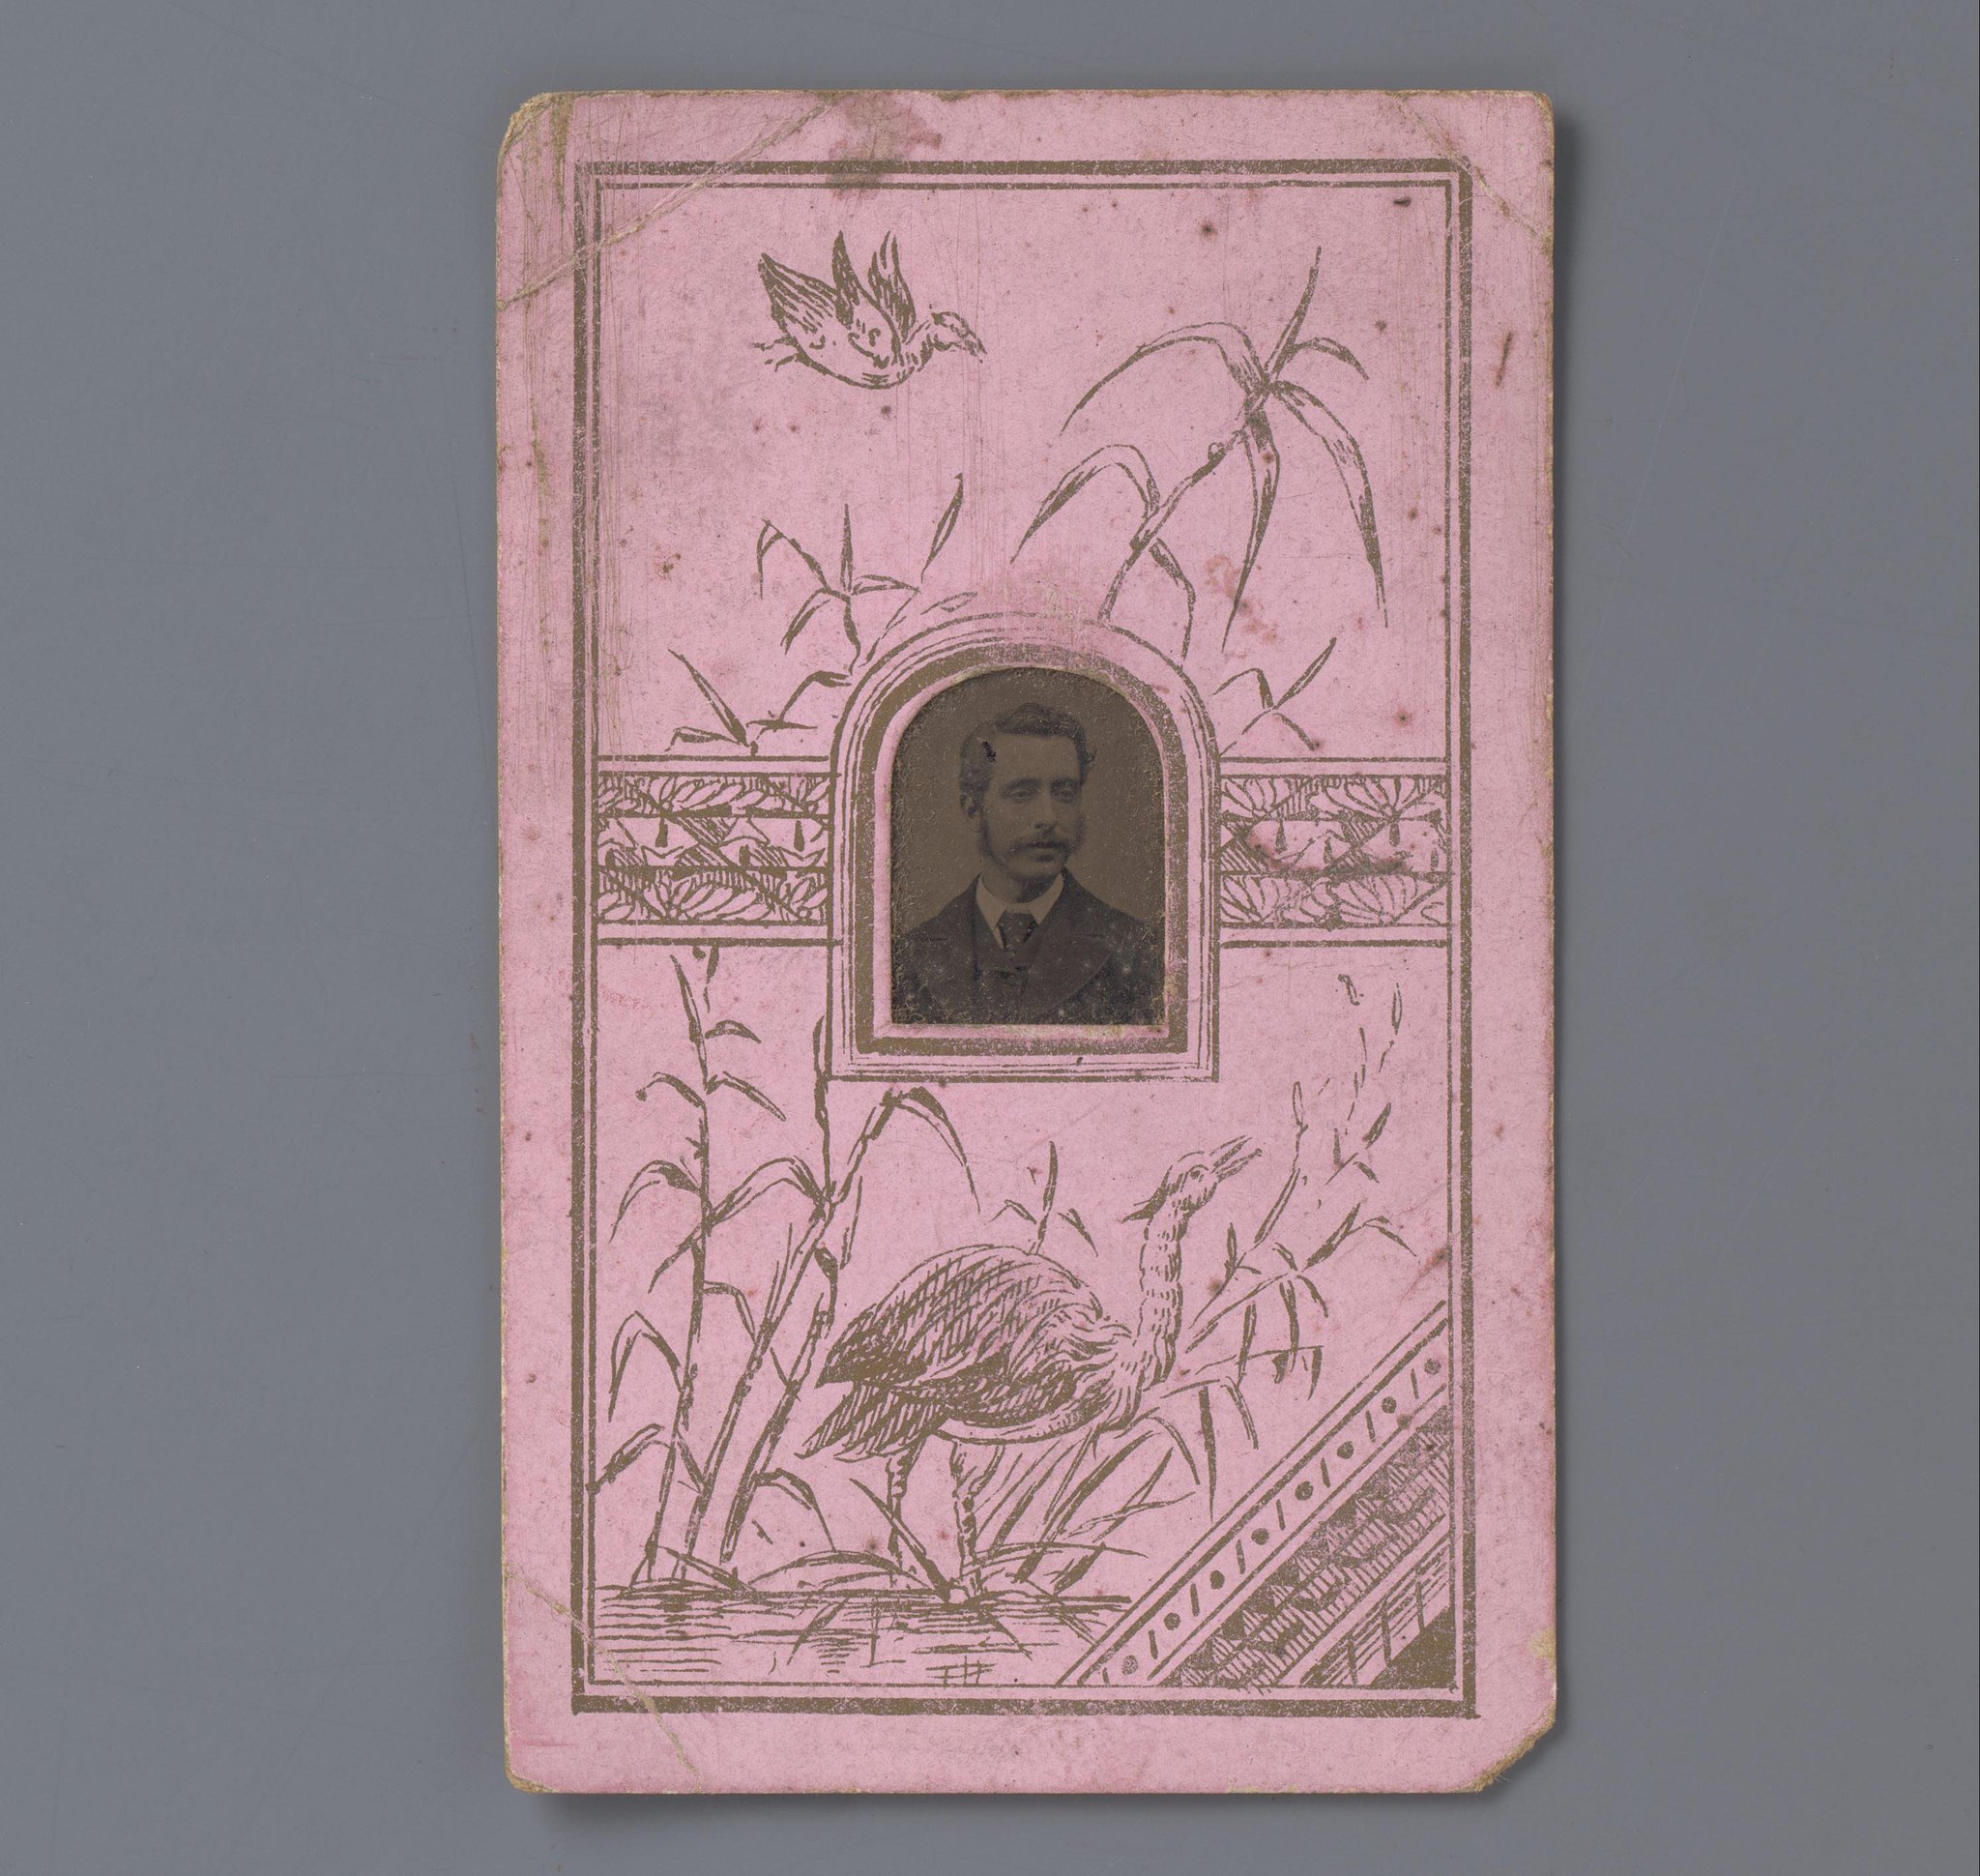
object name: photograph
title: Portret van een onbekende man met snor en bakkebaarden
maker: john george kirby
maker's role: fotograaf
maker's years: 1849-1913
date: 1855-1900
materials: cardboard, iron, paper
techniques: ferrotyping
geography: london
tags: sideburns, moustache, historical persons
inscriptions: inscription: ‘J. G. KIRBY,/ Photographer,/ 295, Edgware Road, London, W./ PRICES./ (...)/ Photography in all its Branches./ J. G. KIRBY,/ 295, EDGWARE ROAD, W.’